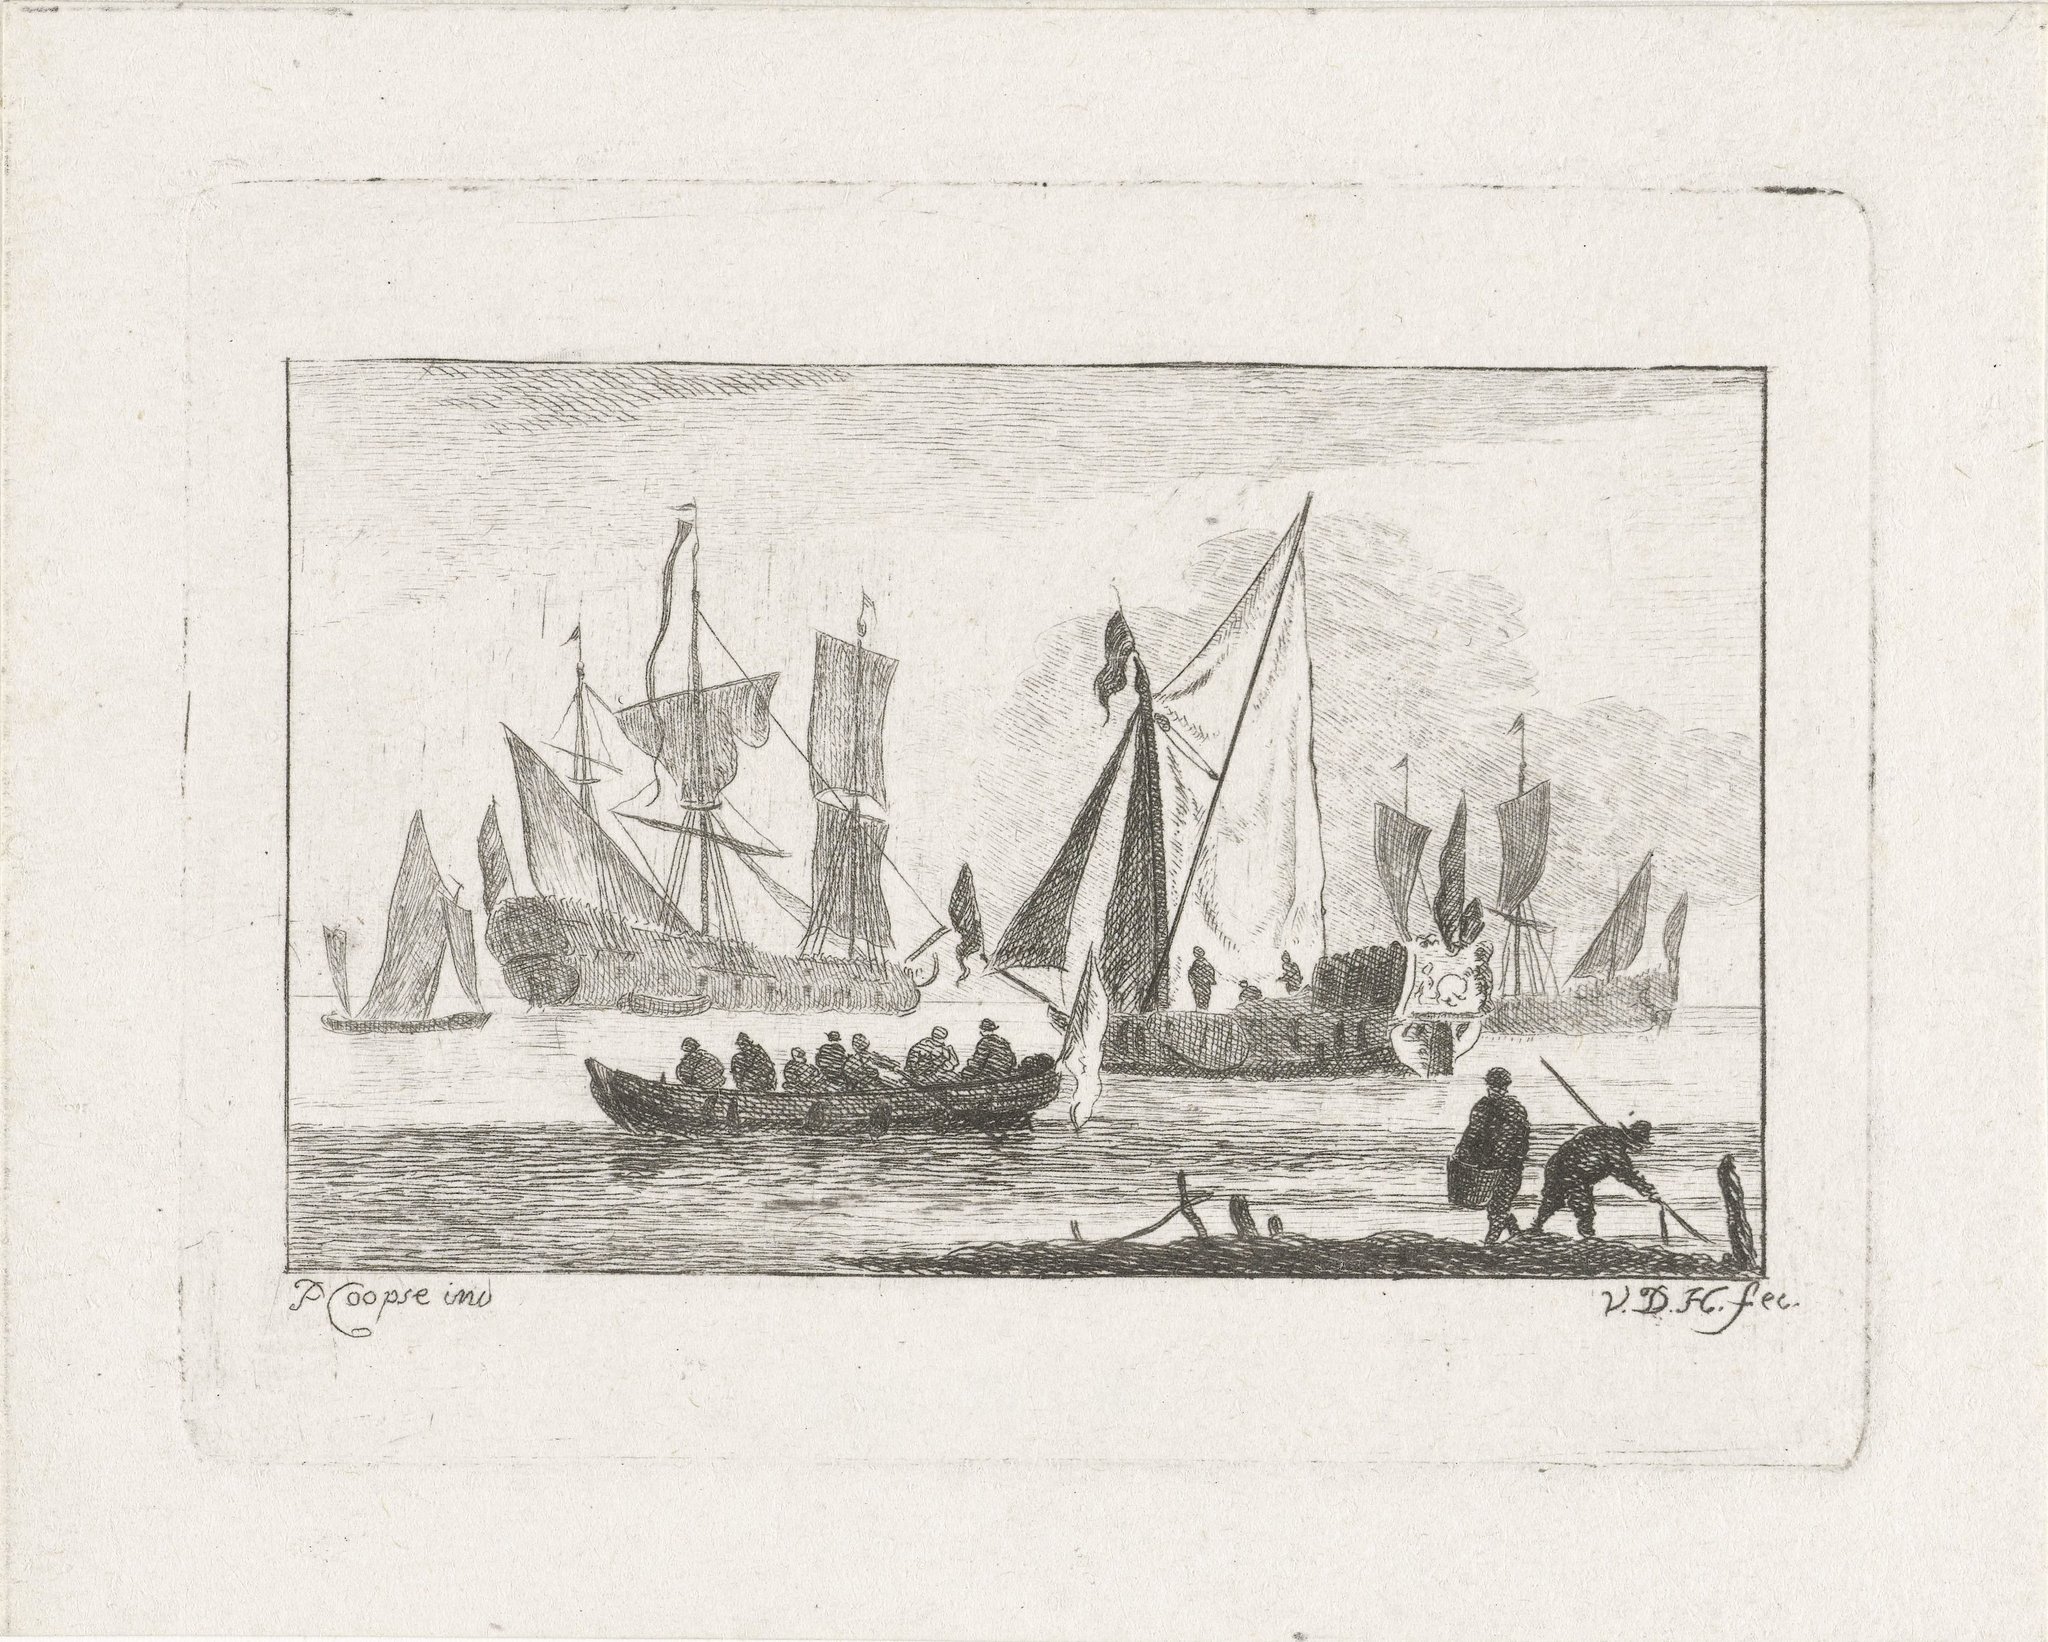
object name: print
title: Zeilschepen en een roeiboot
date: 1745-1785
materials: paper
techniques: etching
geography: northern netherlands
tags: sailing-ship, sailing-boat, rowing-boat, canoe, etc., landscapes with waters, waterscapes, seascapes (in the temperate zone) - hh - ideal landscapes (+ landscape with figures, staffage)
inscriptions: collector's mark: Lugt 240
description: Vele zeilschepen op het water en figuren in een sloep. Op de voorgrond twee figuren op de oever.